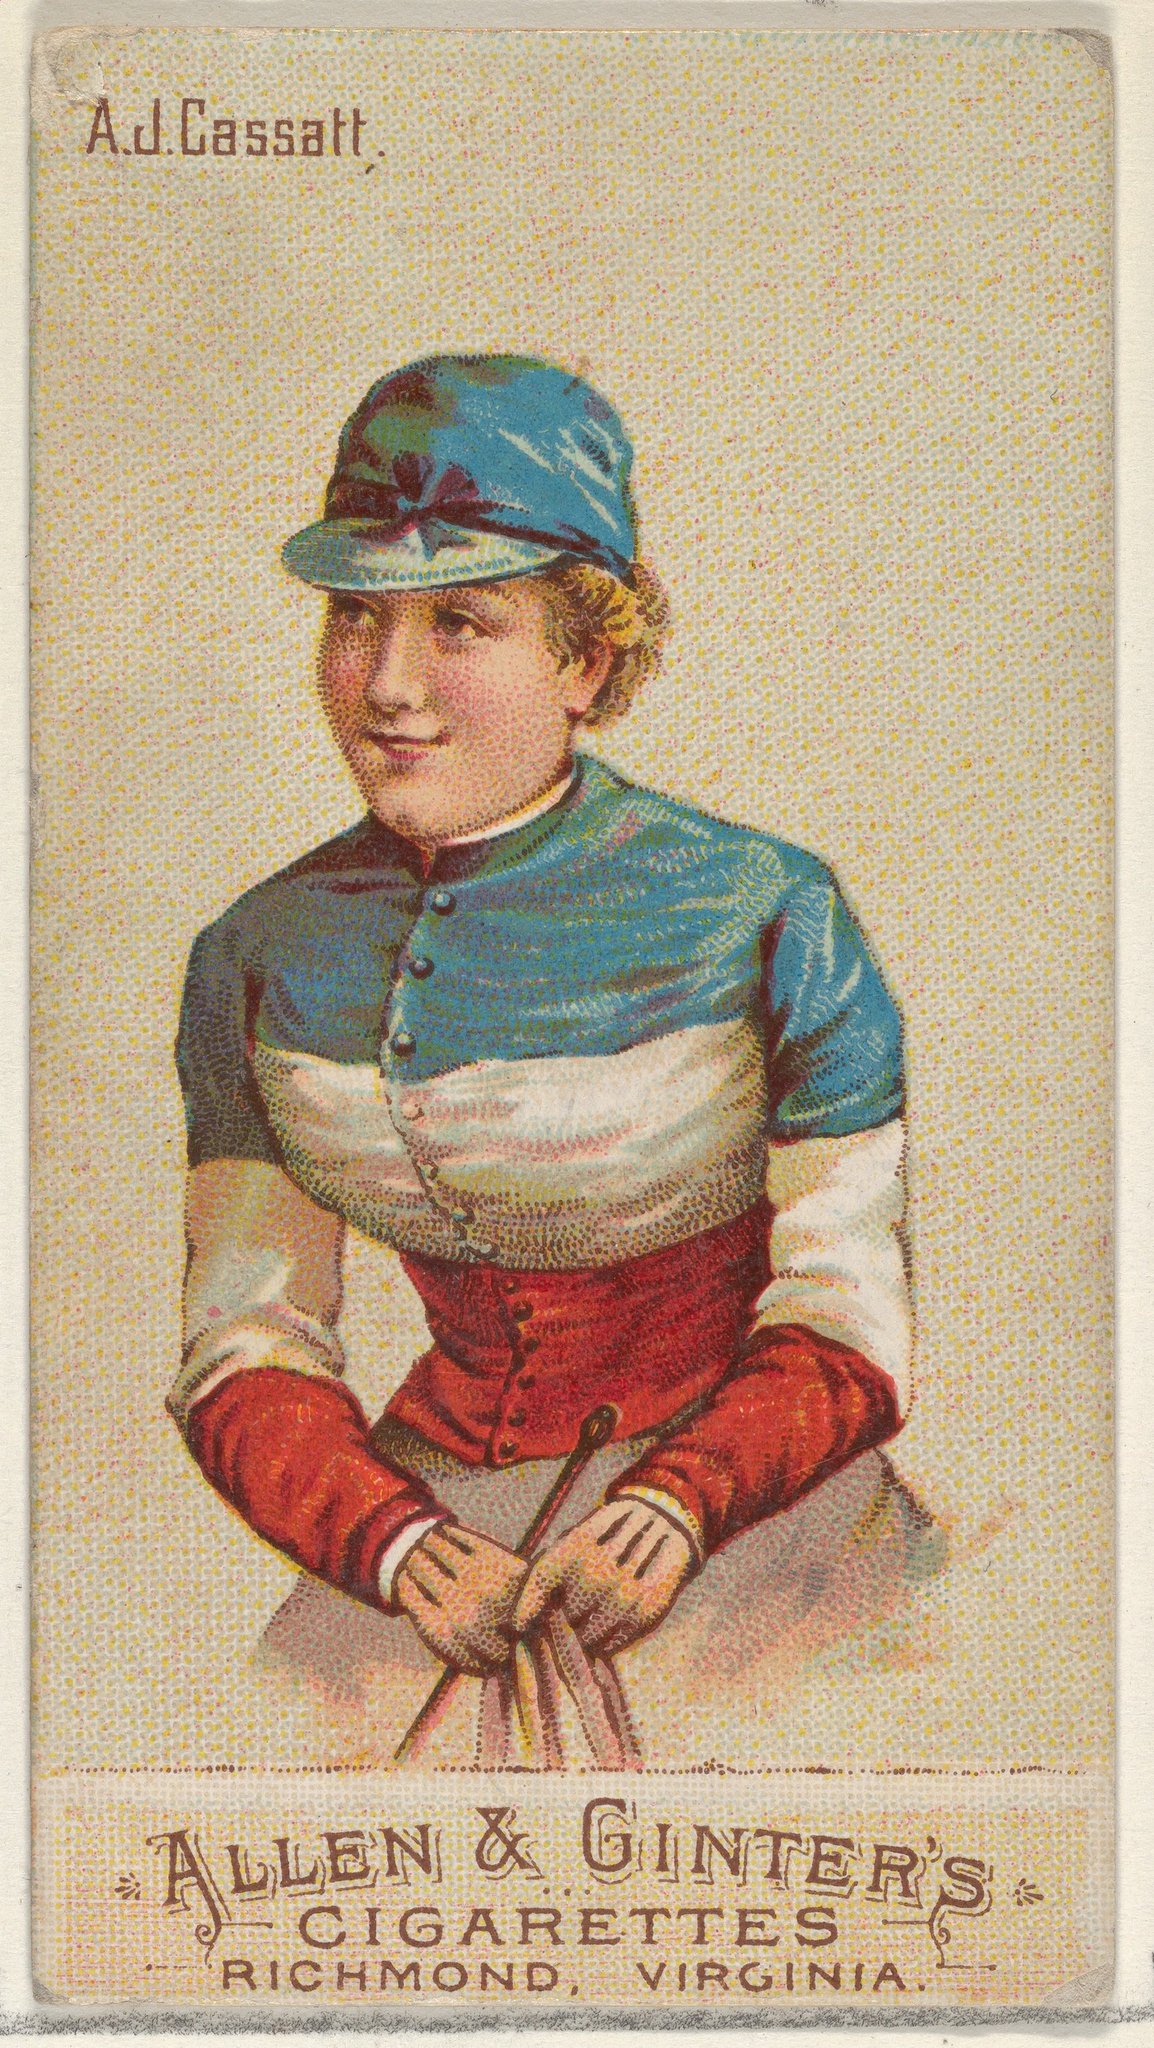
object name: print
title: A.J. Cassatt, from the Racing Colors of the World series (N22b) for Allen & Ginter Cigarettes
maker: allen & ginter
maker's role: publisher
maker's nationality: american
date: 1888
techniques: color lithograph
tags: women,jockeys